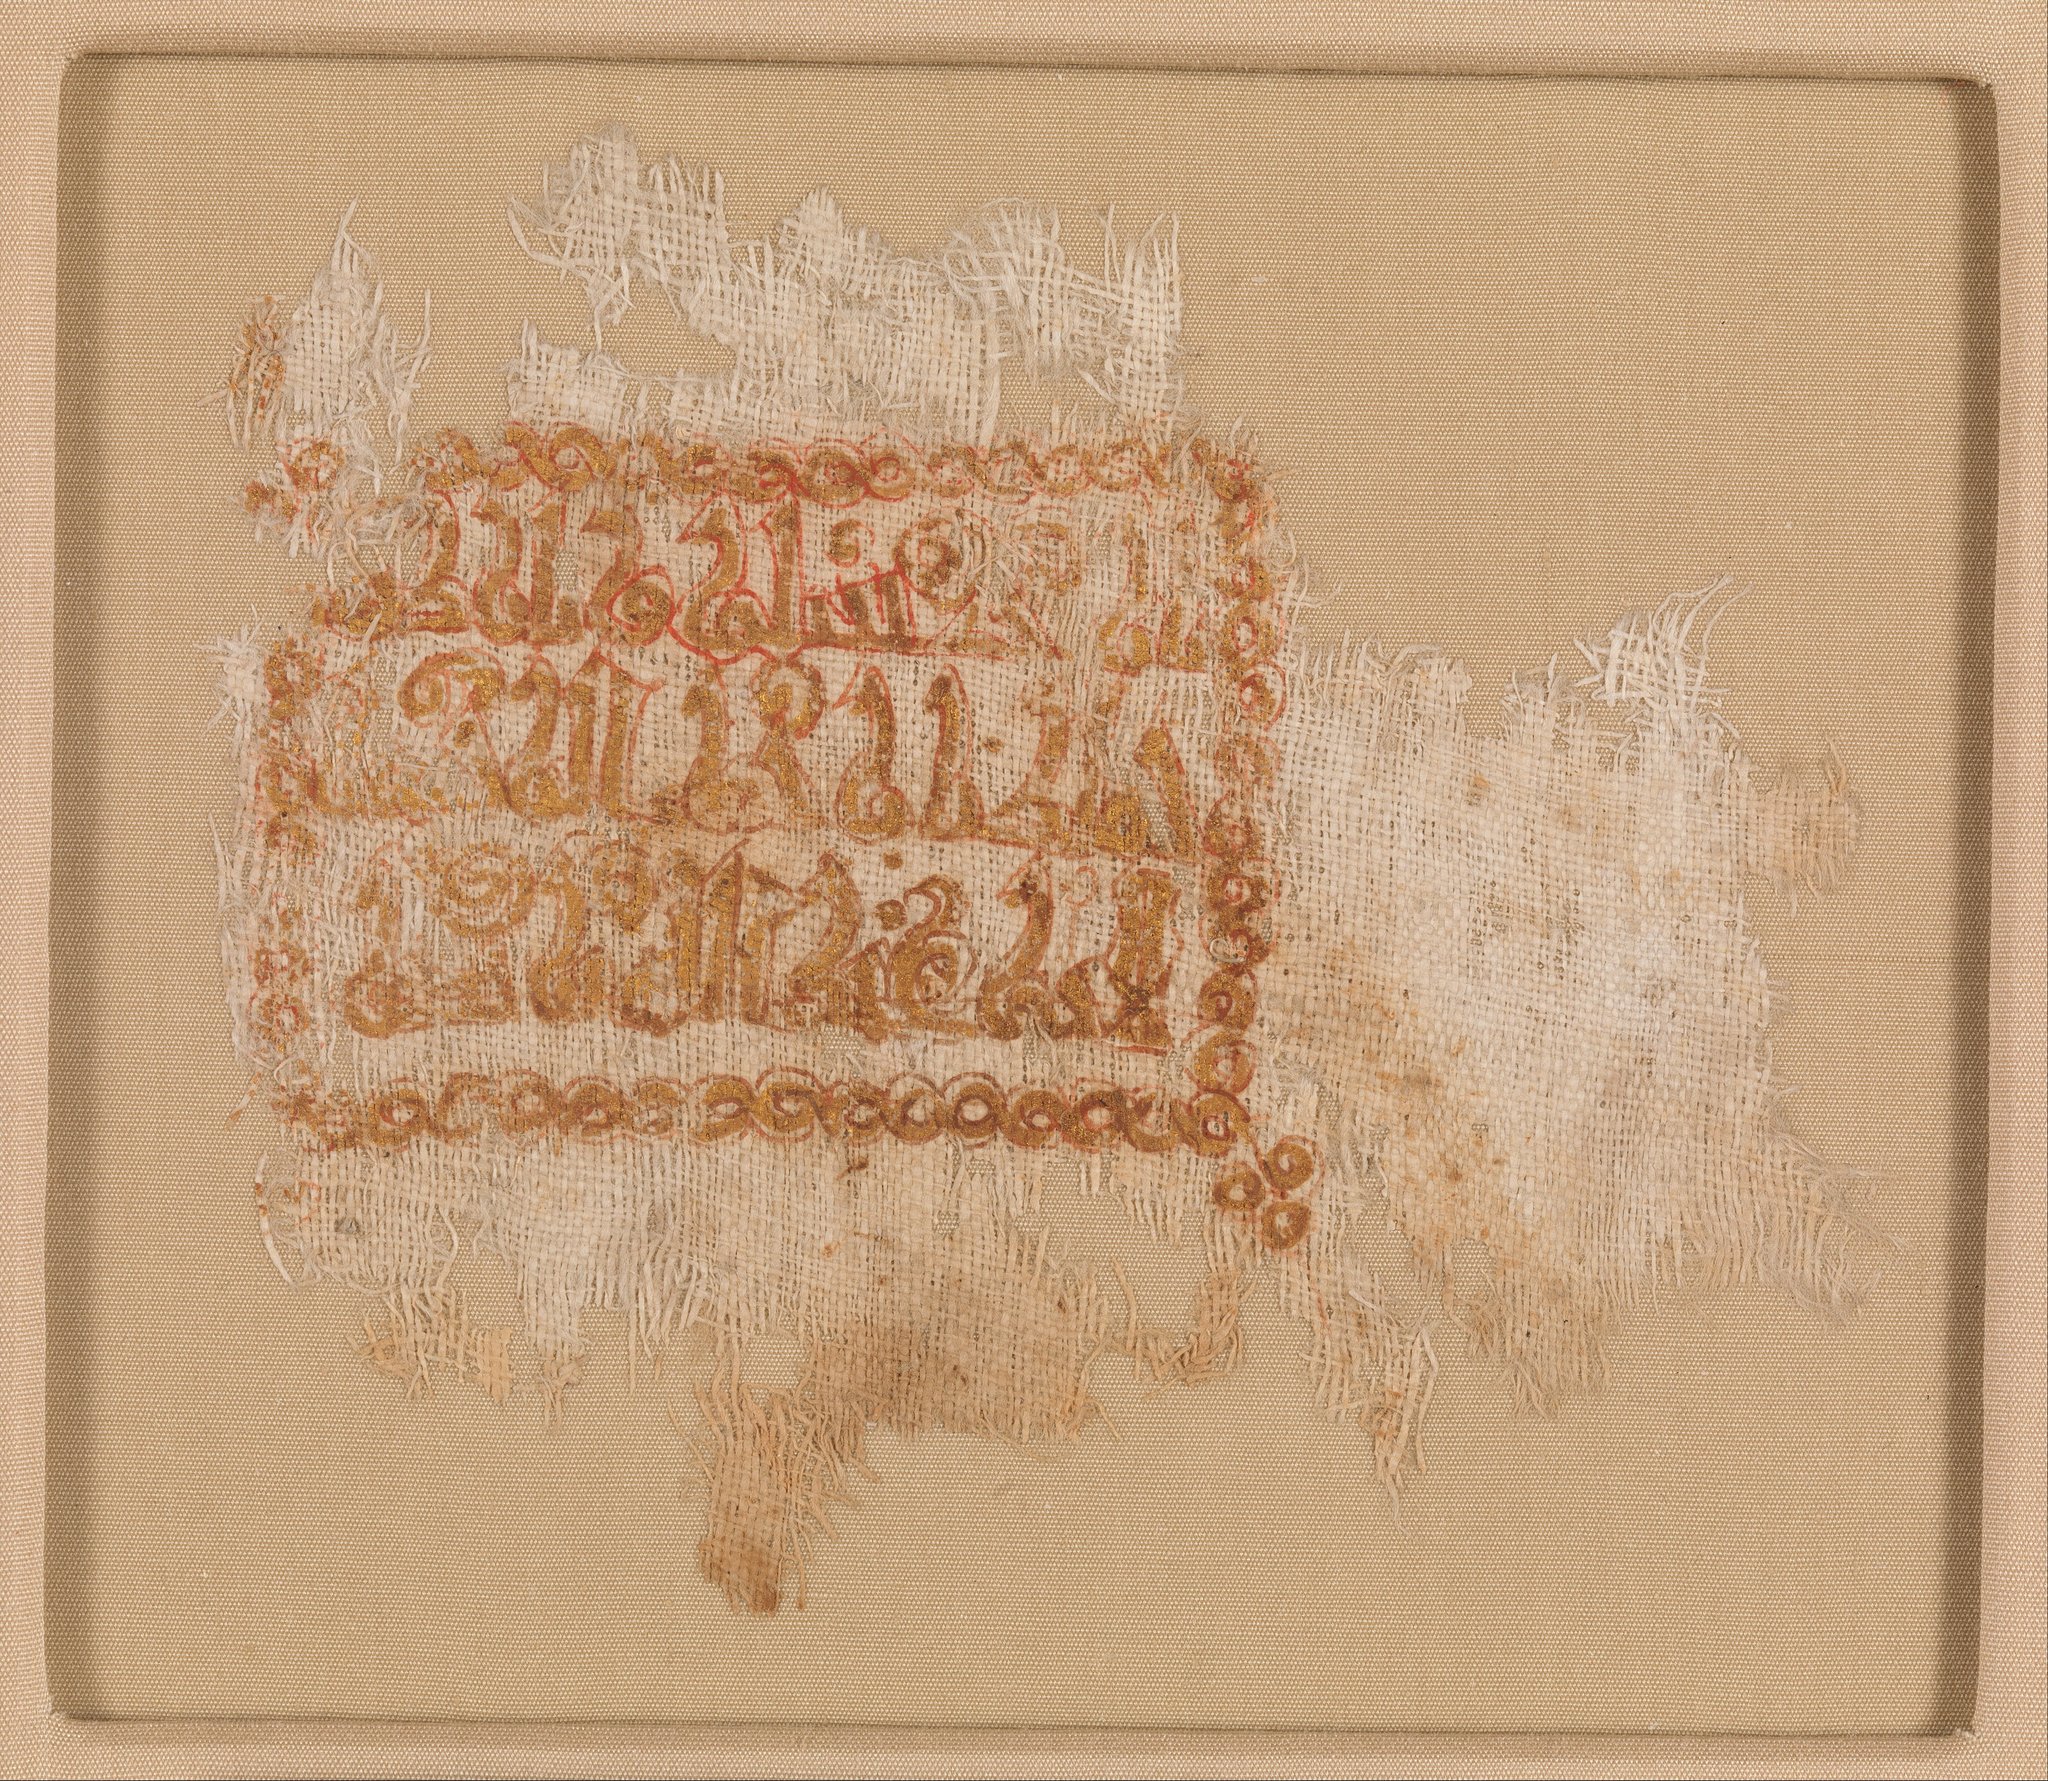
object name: textile fragment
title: Textile Fragment with Inscription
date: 901-1100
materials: cotton, gold, ink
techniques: painting, weave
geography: iraq